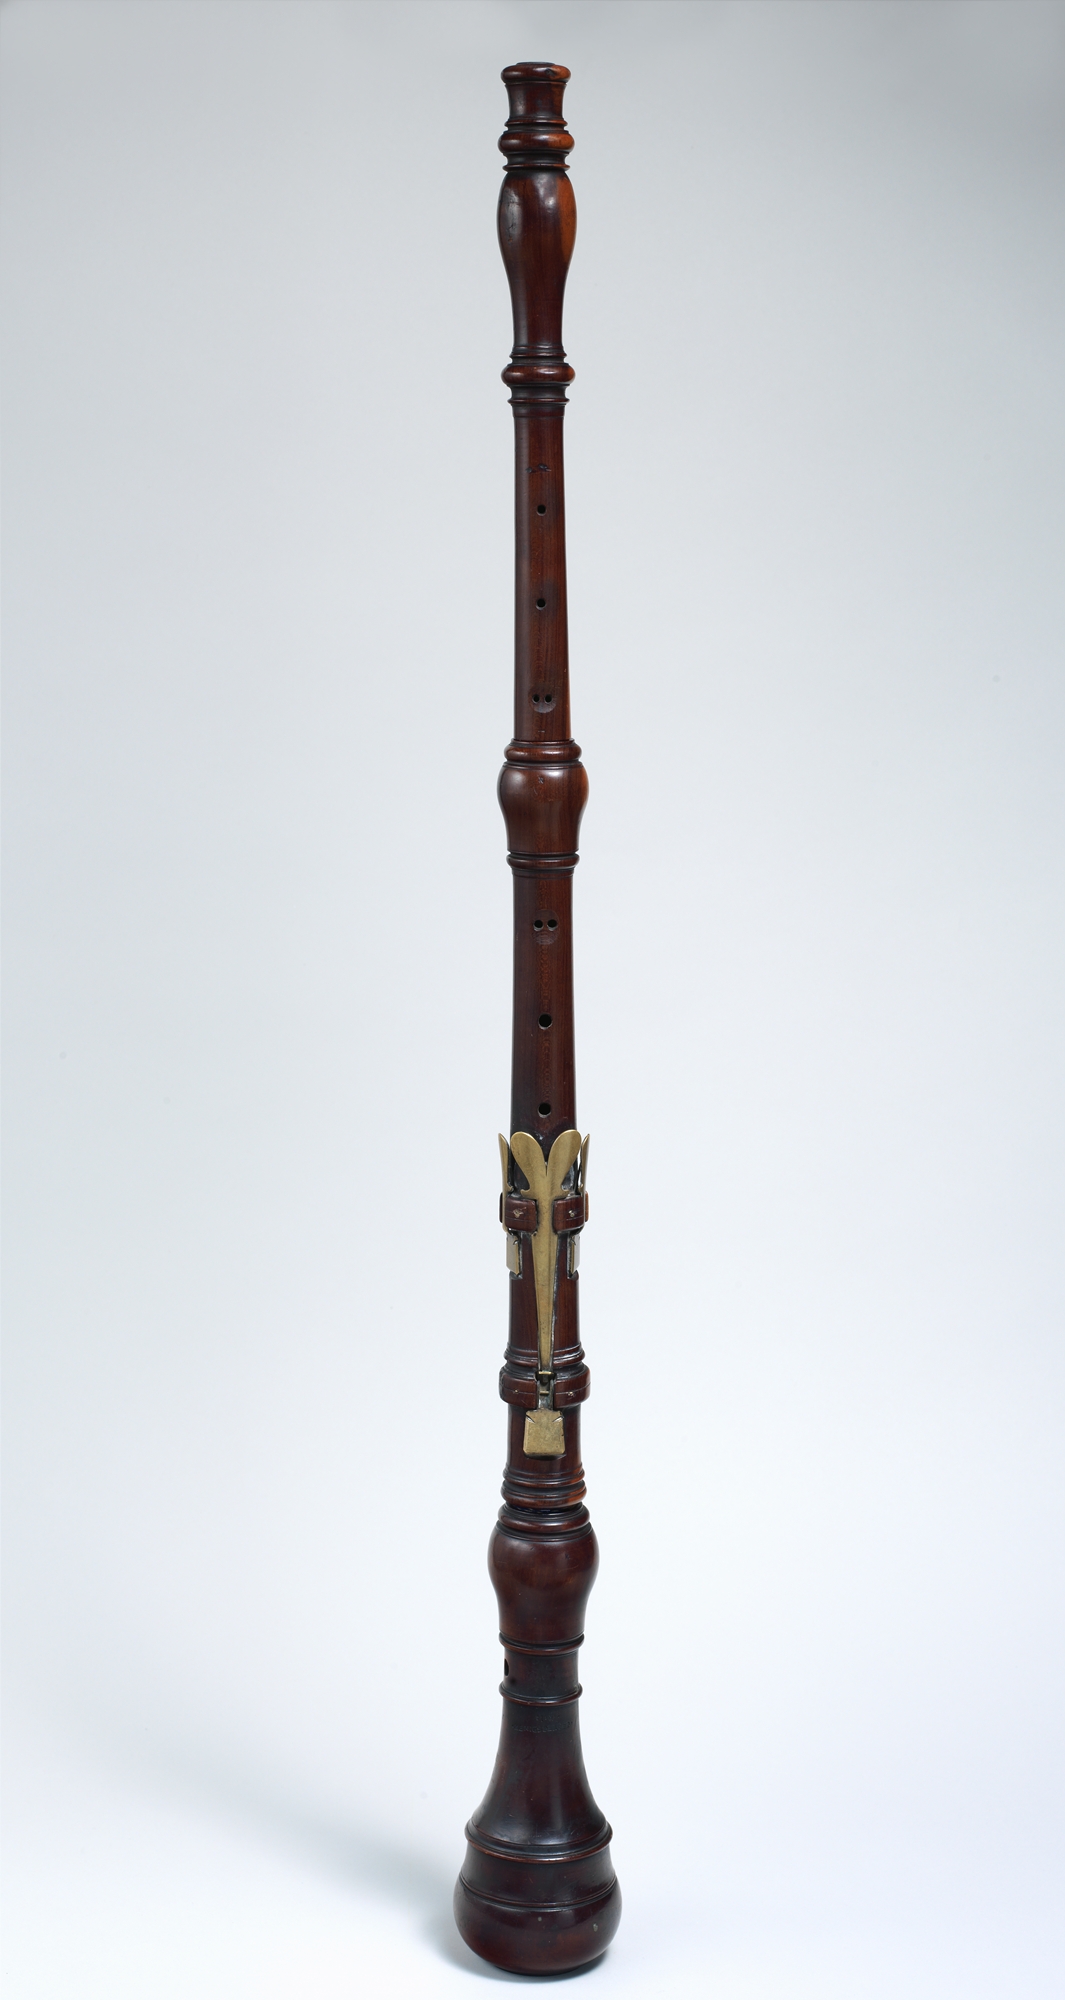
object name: tenor oboe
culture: german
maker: johann wolfgang köningsperger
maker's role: maker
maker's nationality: german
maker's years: 1725-1752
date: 1730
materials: brass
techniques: stain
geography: germany